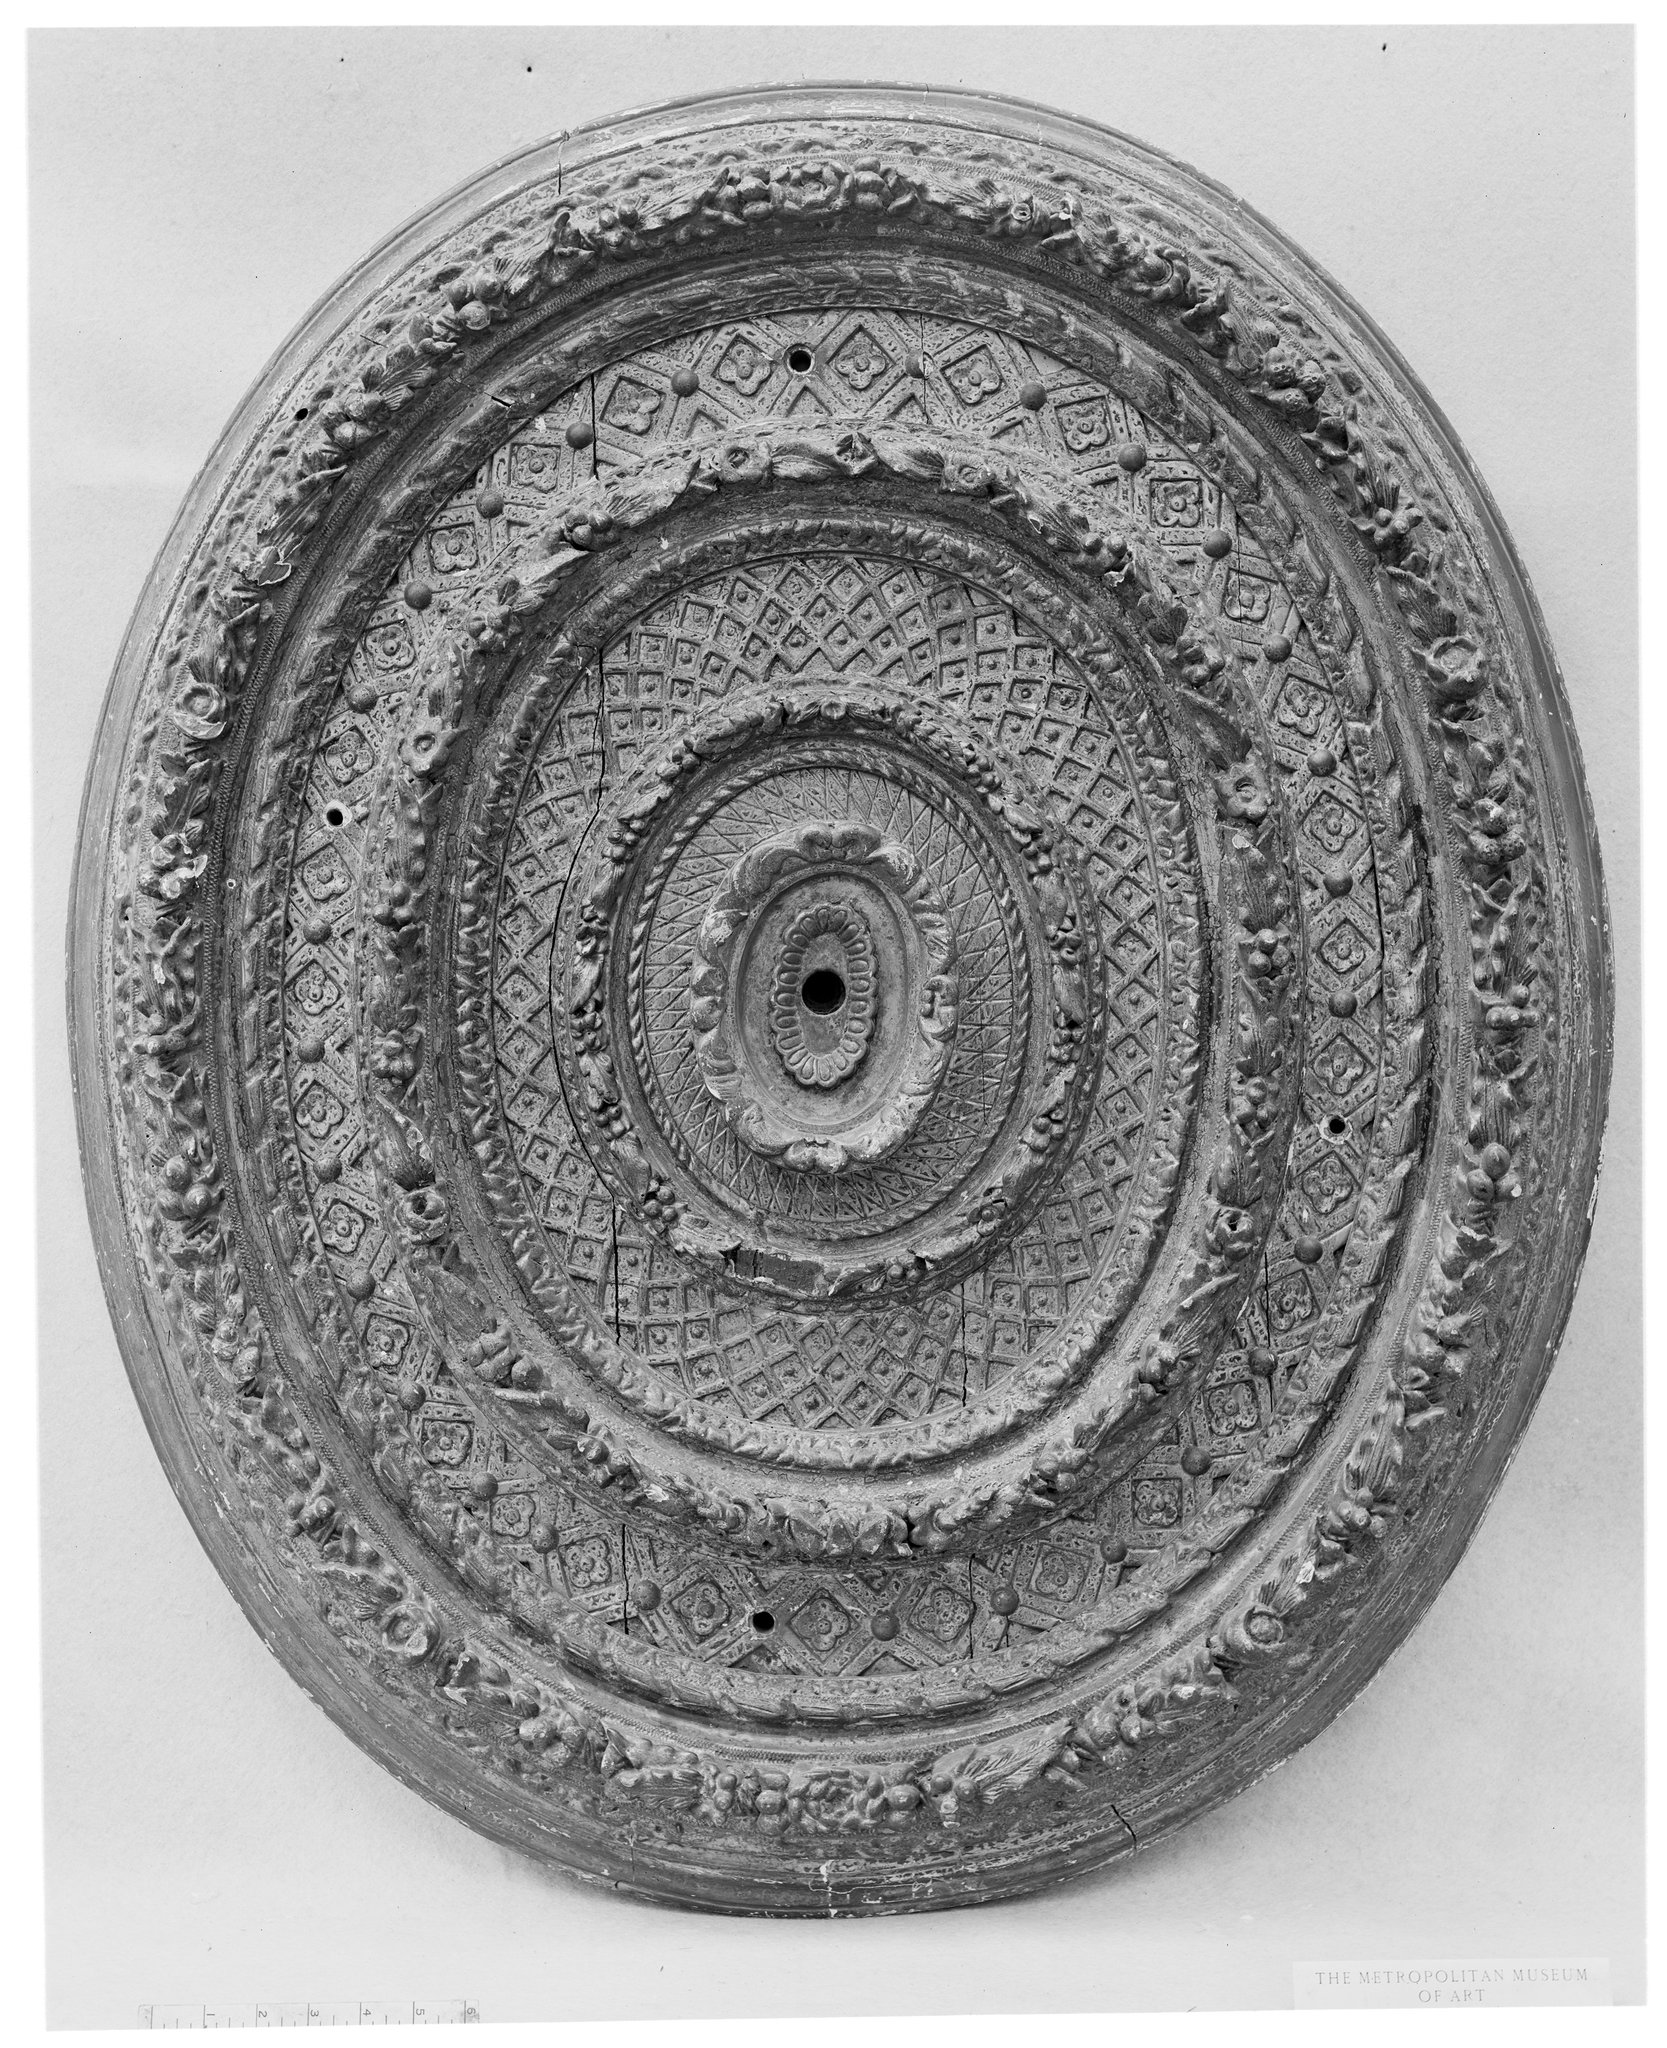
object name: ceiling medallion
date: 1667-1733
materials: gilt, wood